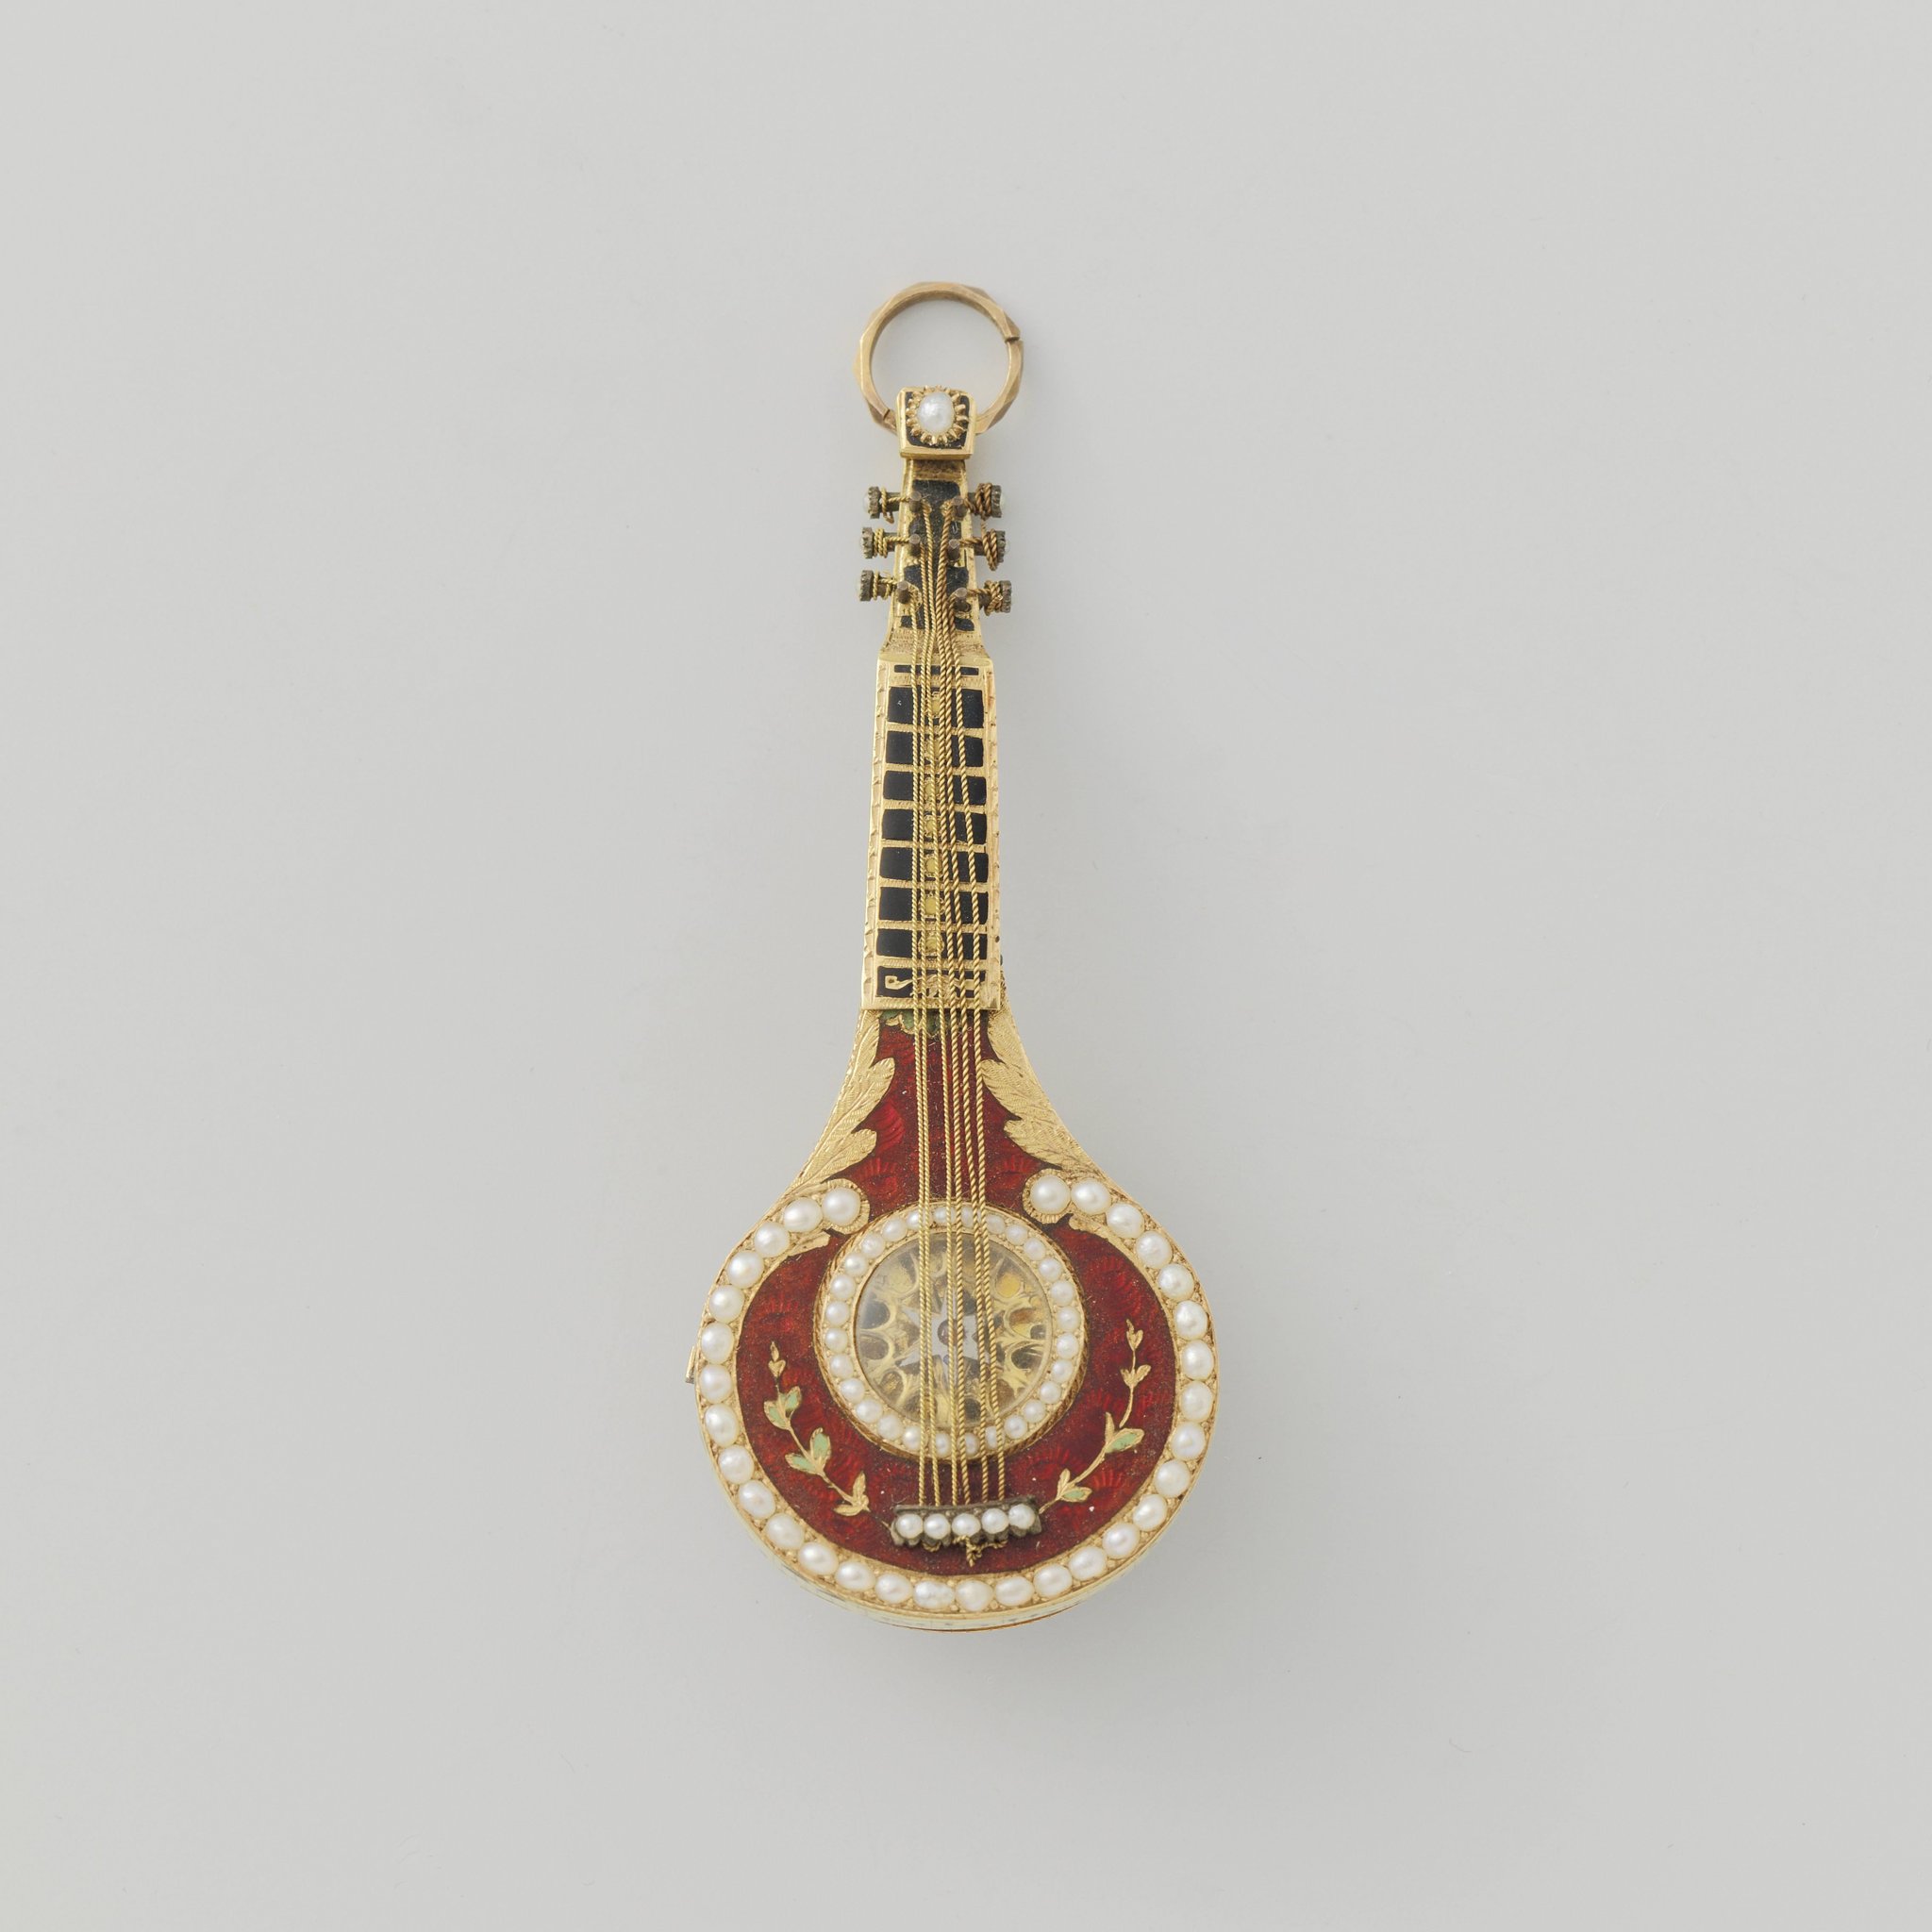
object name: jewellery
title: Mandoline-shaped Watch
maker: Anonymous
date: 1825-1850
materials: glass, gold, pearl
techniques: enameling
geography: switzerland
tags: cithern, mandolin, guitar, balalaika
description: Horloge van geëmailleerd goud in de vorm van een mandoline. De carure is geschilderd met een gedeelte van een partituur.